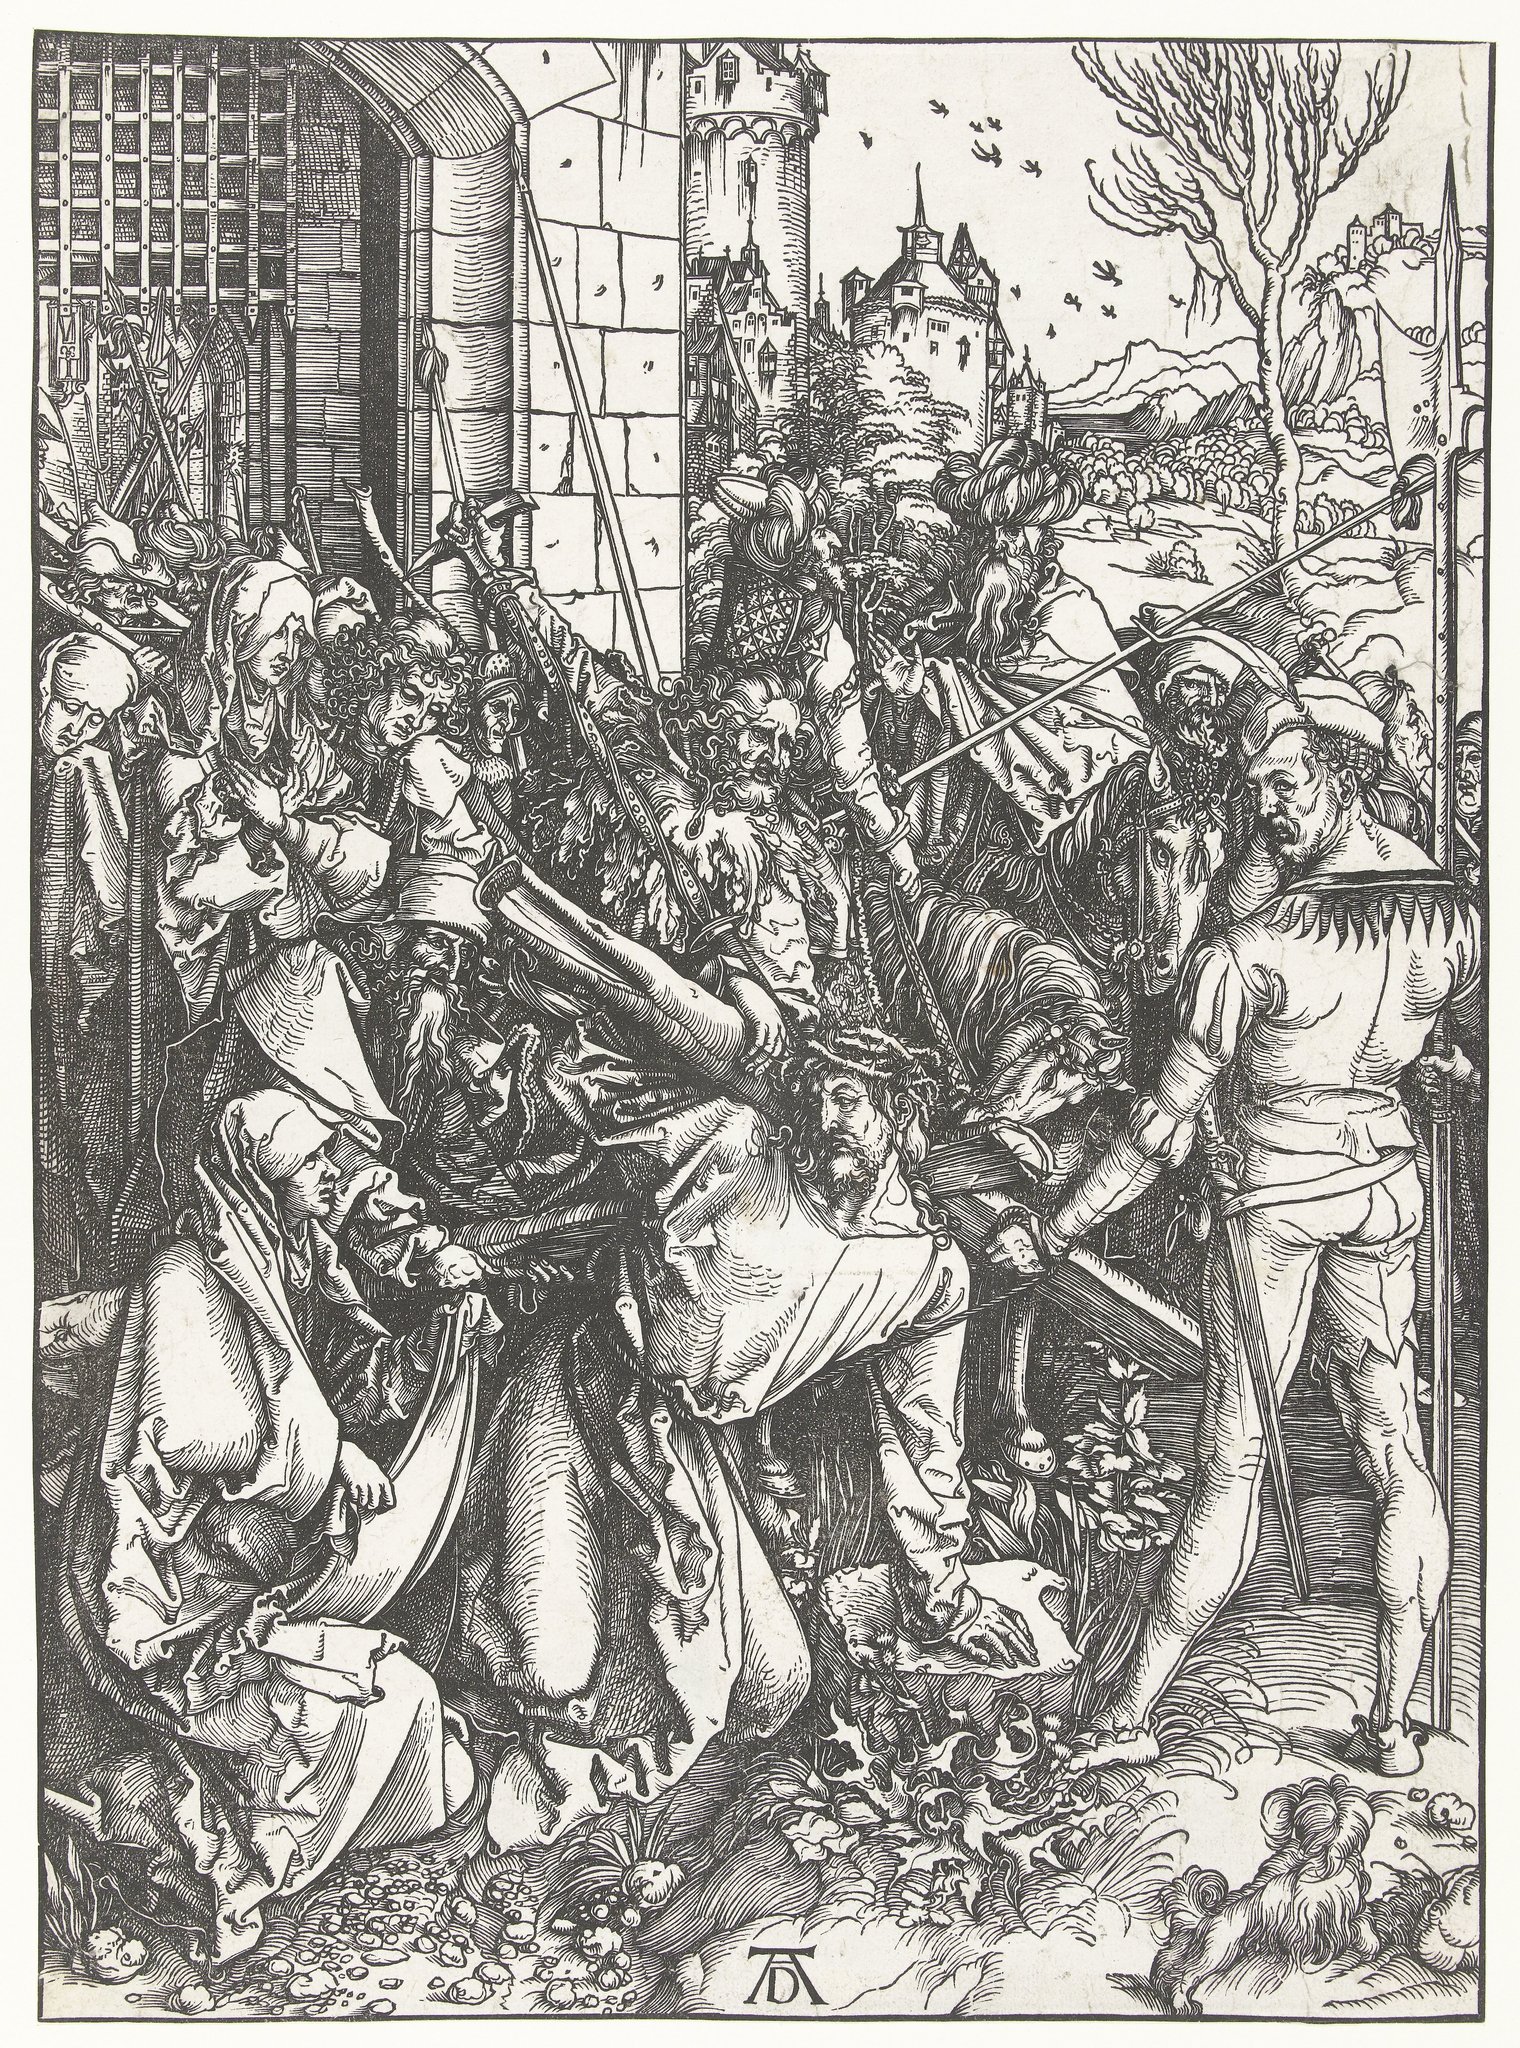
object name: print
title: Kruisdraging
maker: albrecht dürer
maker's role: draughtsman, painter, print maker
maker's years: 1471-1528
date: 1498-1499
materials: paper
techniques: woodcut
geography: nuremberg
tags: christ meets veronica, who has a cloth to wipe christ's face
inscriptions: collector's mark: Lugt 240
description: Christus draagt zijn kruis, gevolgd door een menigte mensen; Veronica staat met de zweetdoek naast hem. Deze prent is onderdeel van de prentserie 'De grote Passie', bestaande uit een titelprent en 11 scènes uit het Lijdensverhaal.